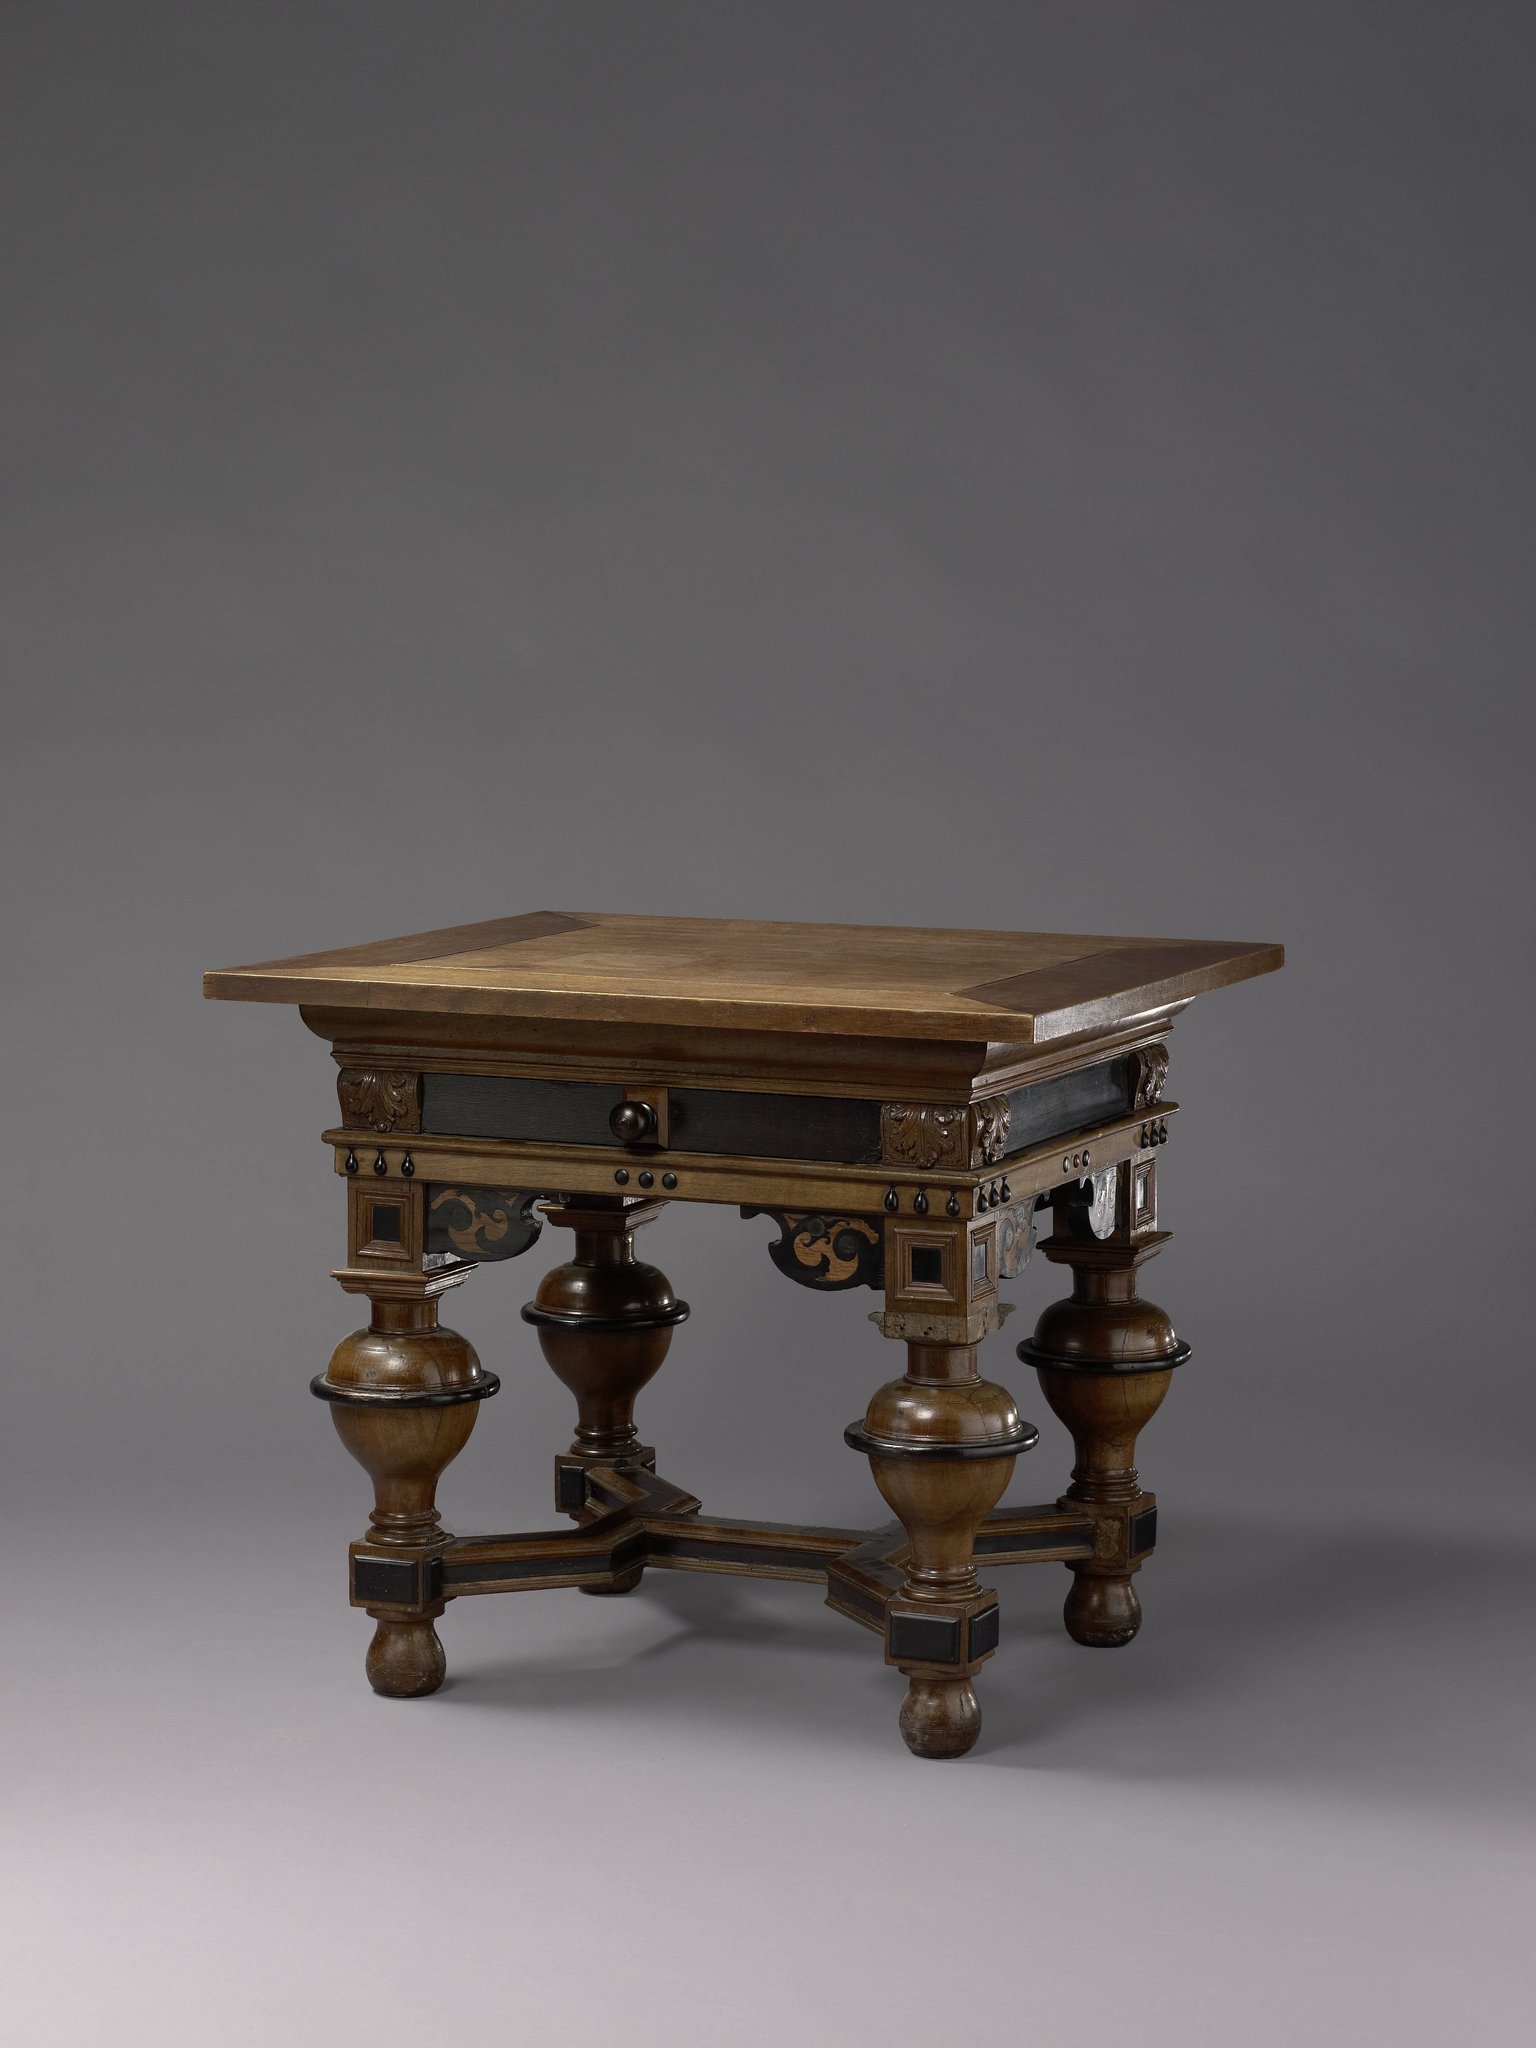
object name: furniture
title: Balpoottafel met lade op geringde balpoten verbonden door een H-vormig kruis met ingelegde biezen; versierd met uitgezaagde ebben voluten, druppels en platte knoppen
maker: Anonymous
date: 1650-1675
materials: wood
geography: the hague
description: Balpoottafel van notenhout, met zwart gebeitste onderdelen en versieringen in ebbenhout. De geringde balpoten zijn verbonden door een H-vormig kruis met ingelegde biezen. De huizen zijn met ebbenhouten spiegels belijmd. De regels worden in de hoeken gesteund door voluten belijmd met ajour uitgezaagde ebbenhouten voluten. Boven de huizen op de regels zijn drie ebbenhouten druppels en in het midden drie platte knoppen aangebracht; op de hoeken staan met acanthusblad versierde consoles, waartussen plinten. Lade.